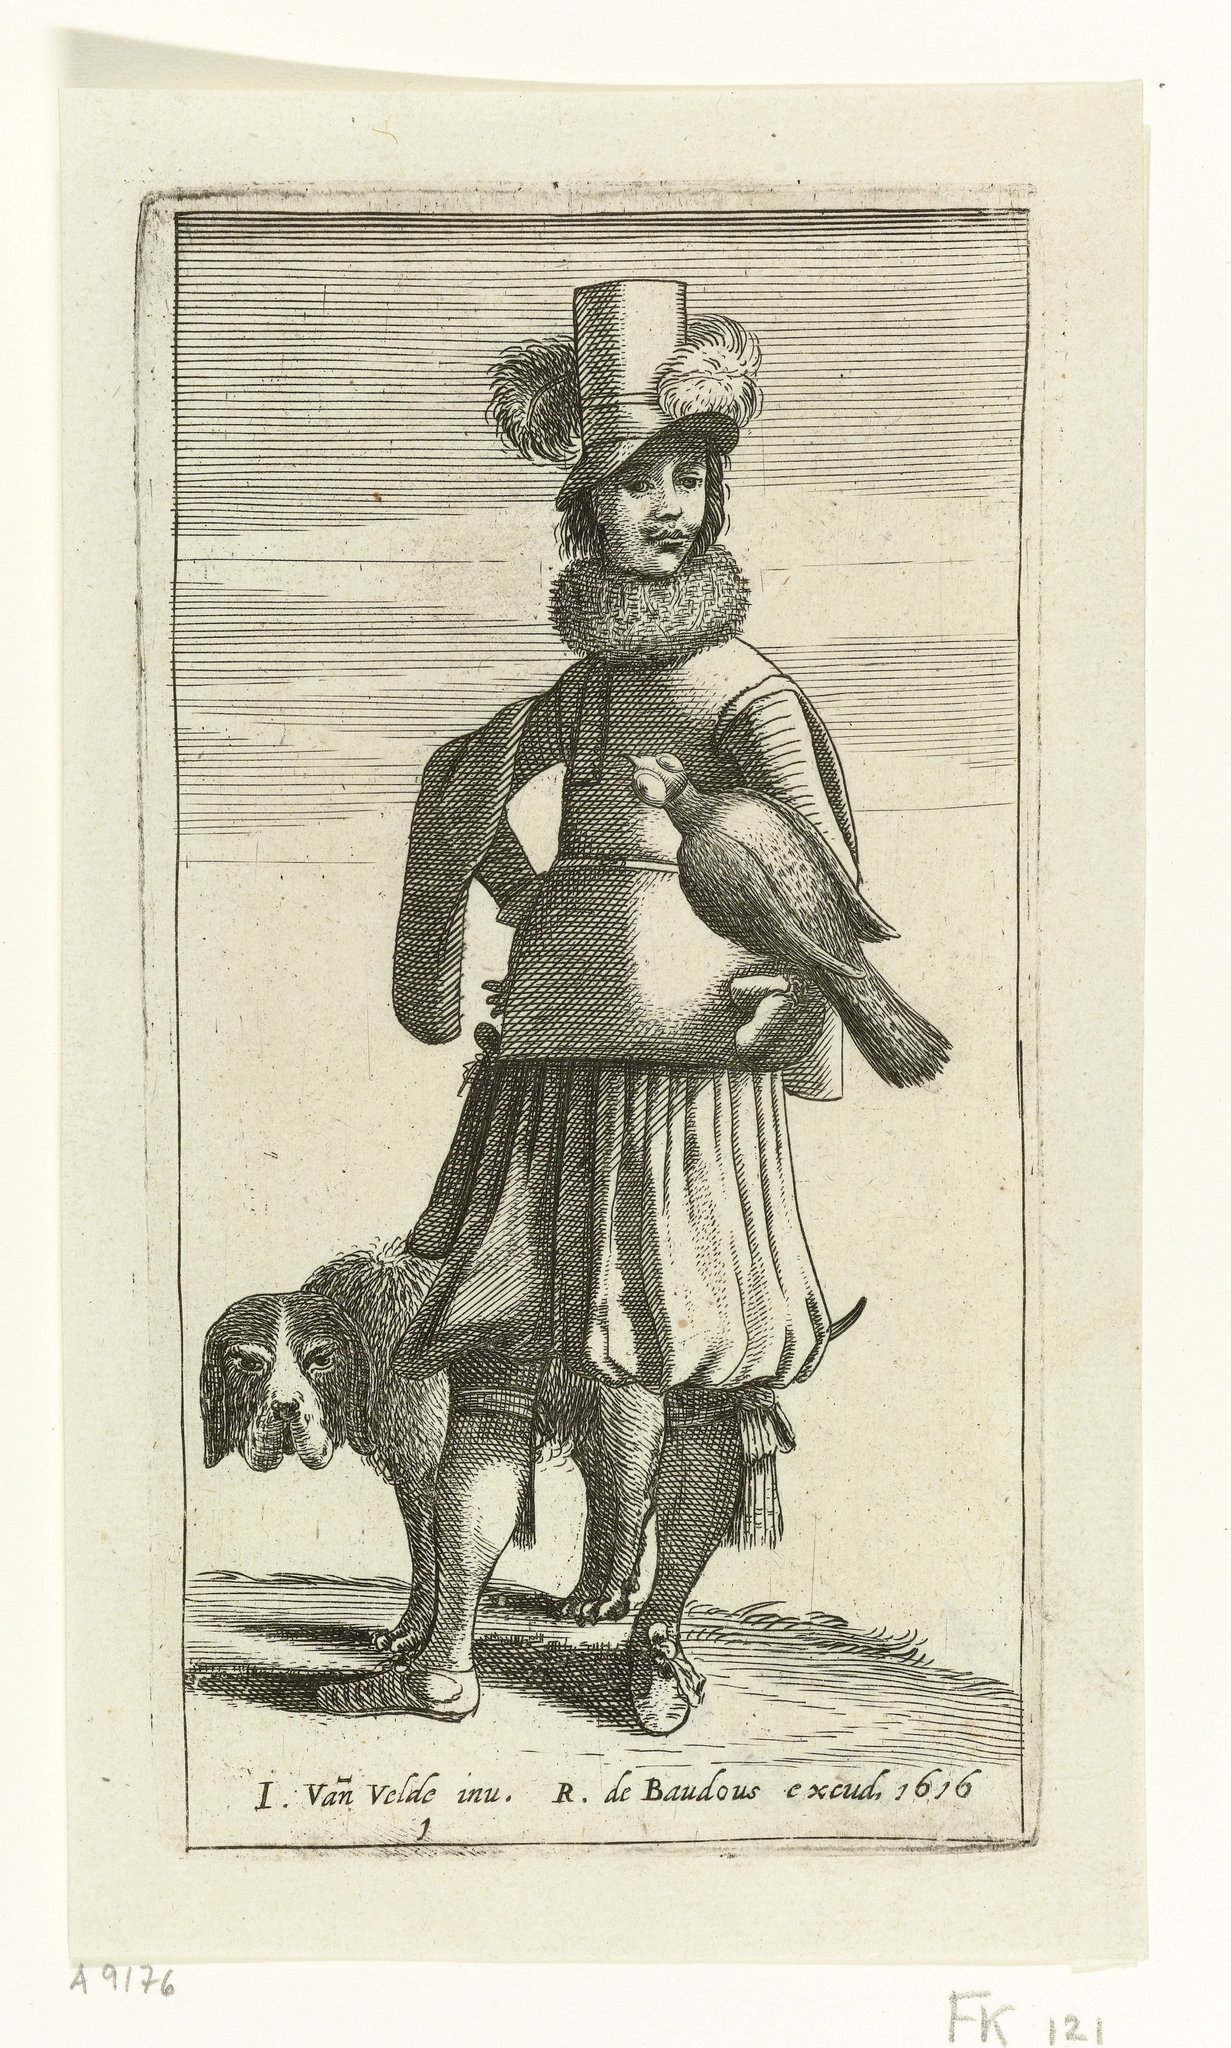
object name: print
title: Valkenier met jachthond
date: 1616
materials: paper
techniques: engraving, etching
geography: low countries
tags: sports, games ~ animals (+ hunting with falcon, hawk; falconry)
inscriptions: address and date: ‘R. de Baudous excud. 1616’, collector's mark: Lugt 2228, signature: ‘I. Van Velde inv.’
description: Elegant geklede valkenier, valk op de arm, staand, rechterhand in de zij. Achter hem een jachthond. Eerste prent uit serie van vier prenten met valkeniers.